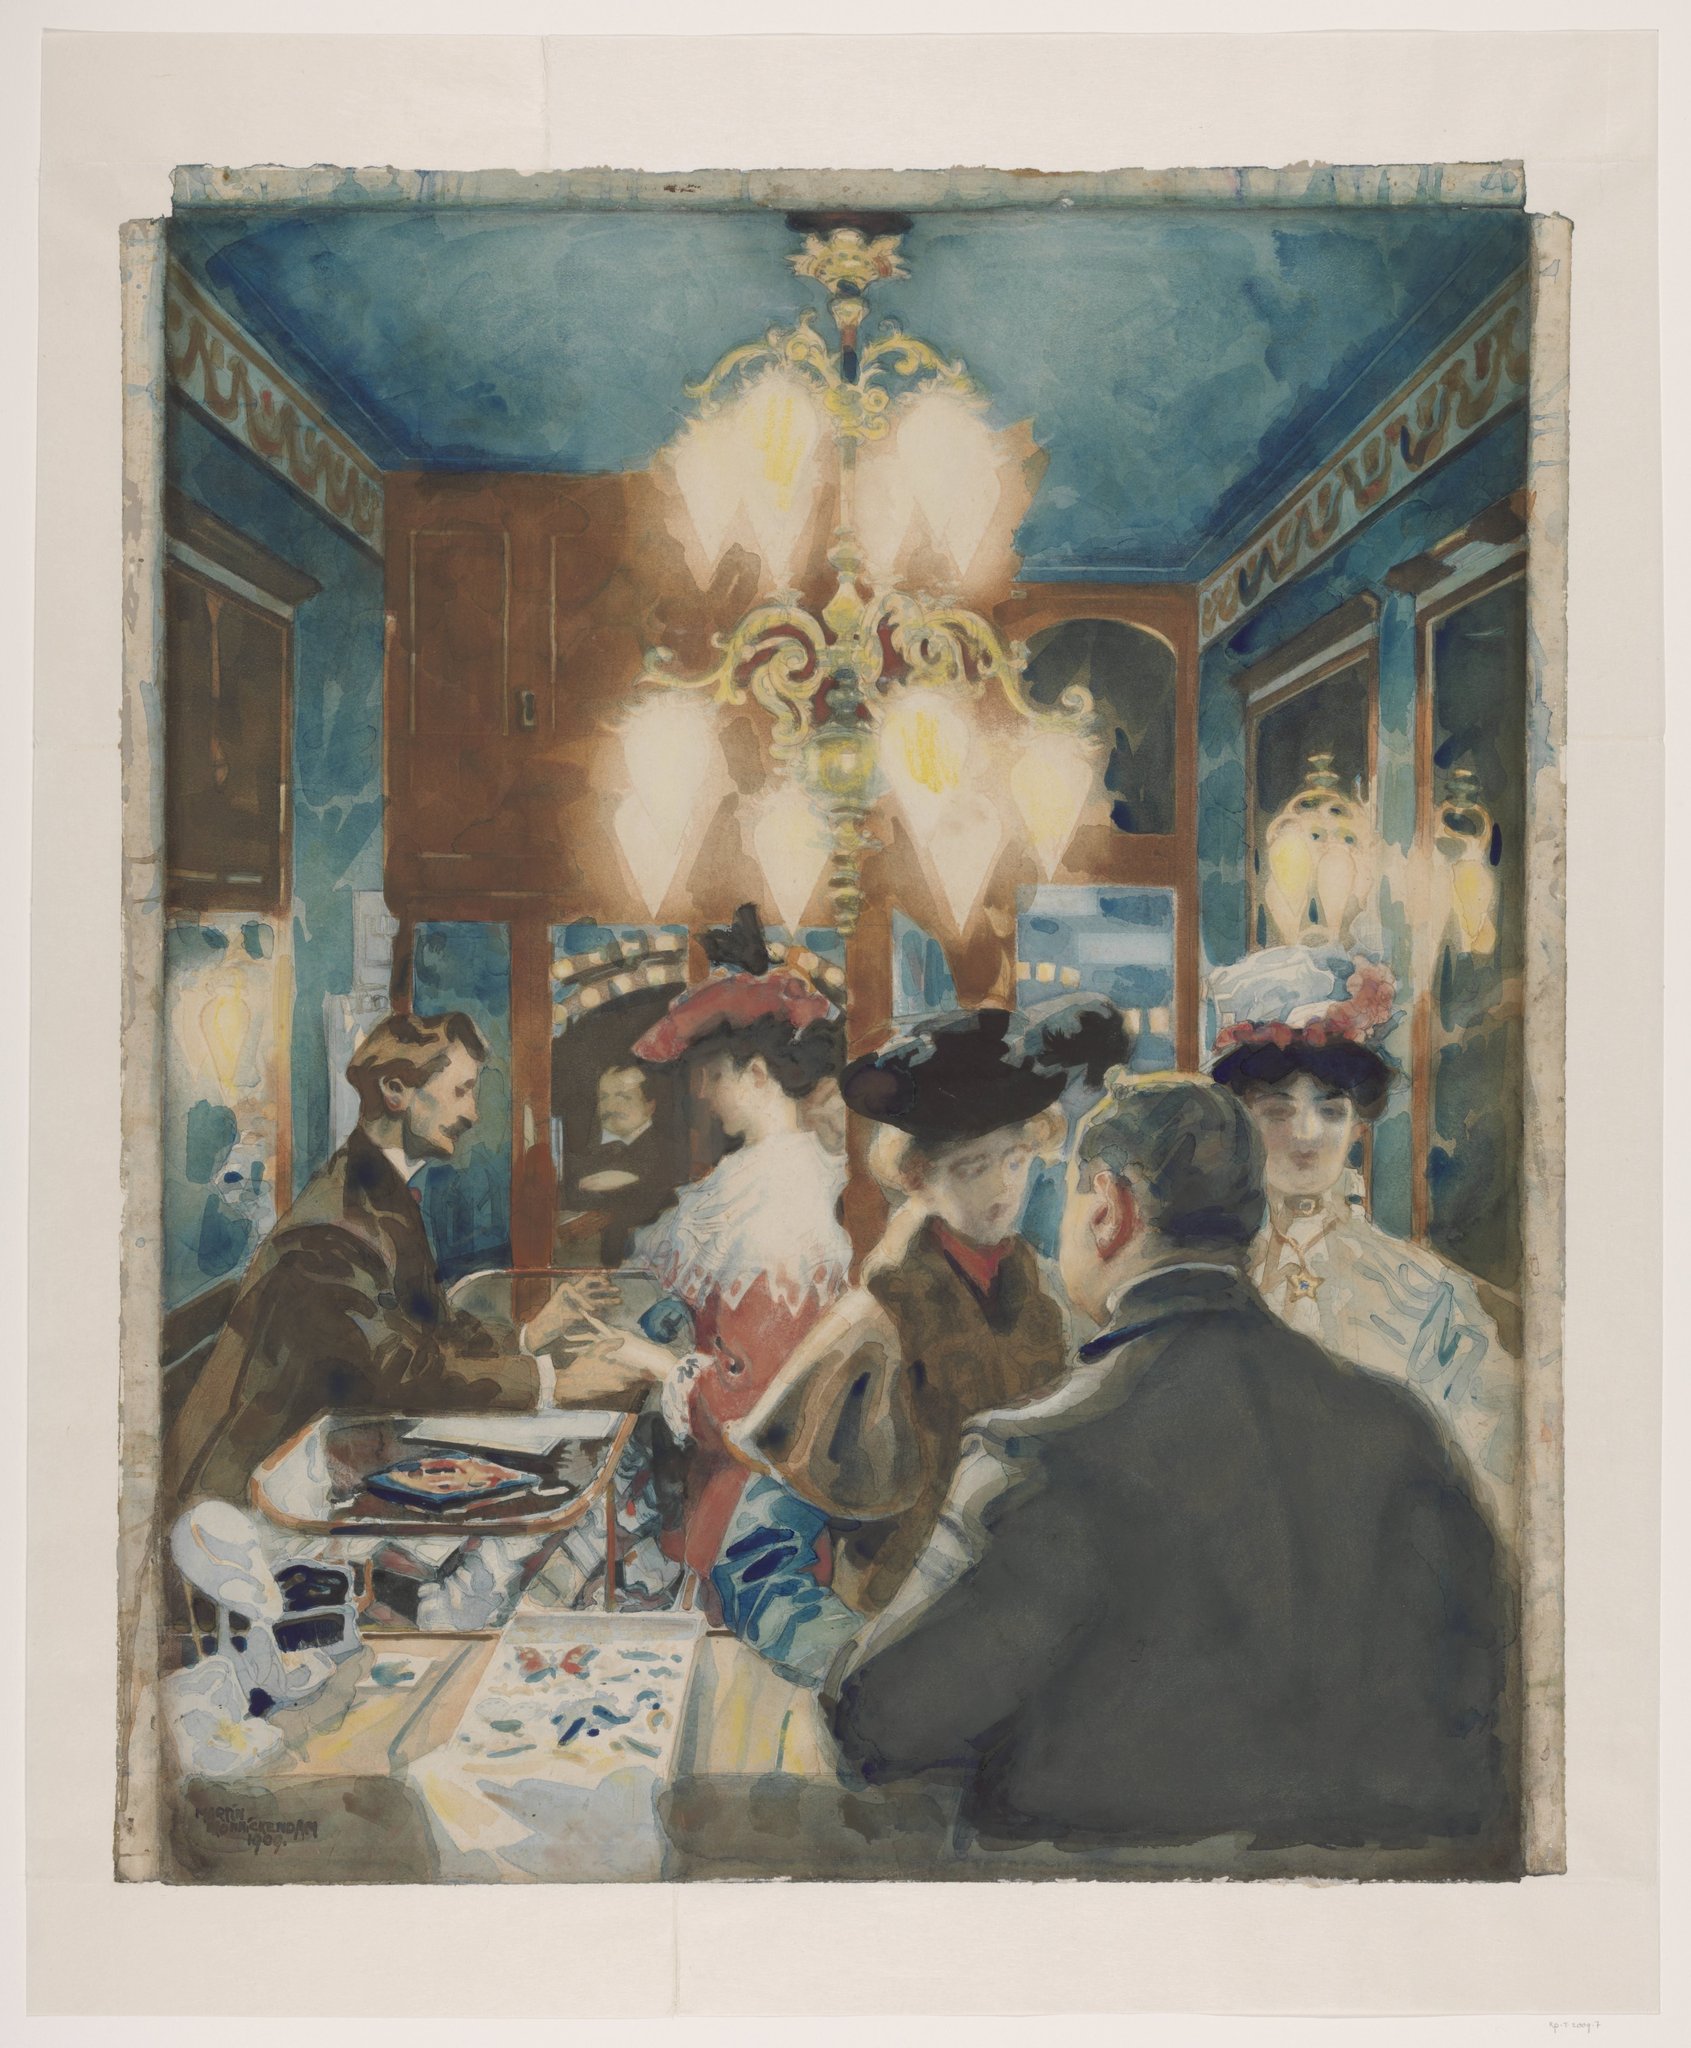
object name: watercolor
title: Bij den Juwelier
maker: martin monnickendam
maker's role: draughtsman, painter, print maker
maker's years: 1874-1943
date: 1909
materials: paper, pencil, watercolor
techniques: brush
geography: amsterdam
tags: jeweller, goldsmith, silversmith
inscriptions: signature and date: ‘Martin Monnickendam // 1909’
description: Interieur van een sieradenwinkel in de Kalverstraat 52 te Amsterdam. Die juwelier was de broer, Jacques, van de kunstenaar, wiens zaak gelegen was tegenover de kunsthandel Frans Buffa en Zonen.